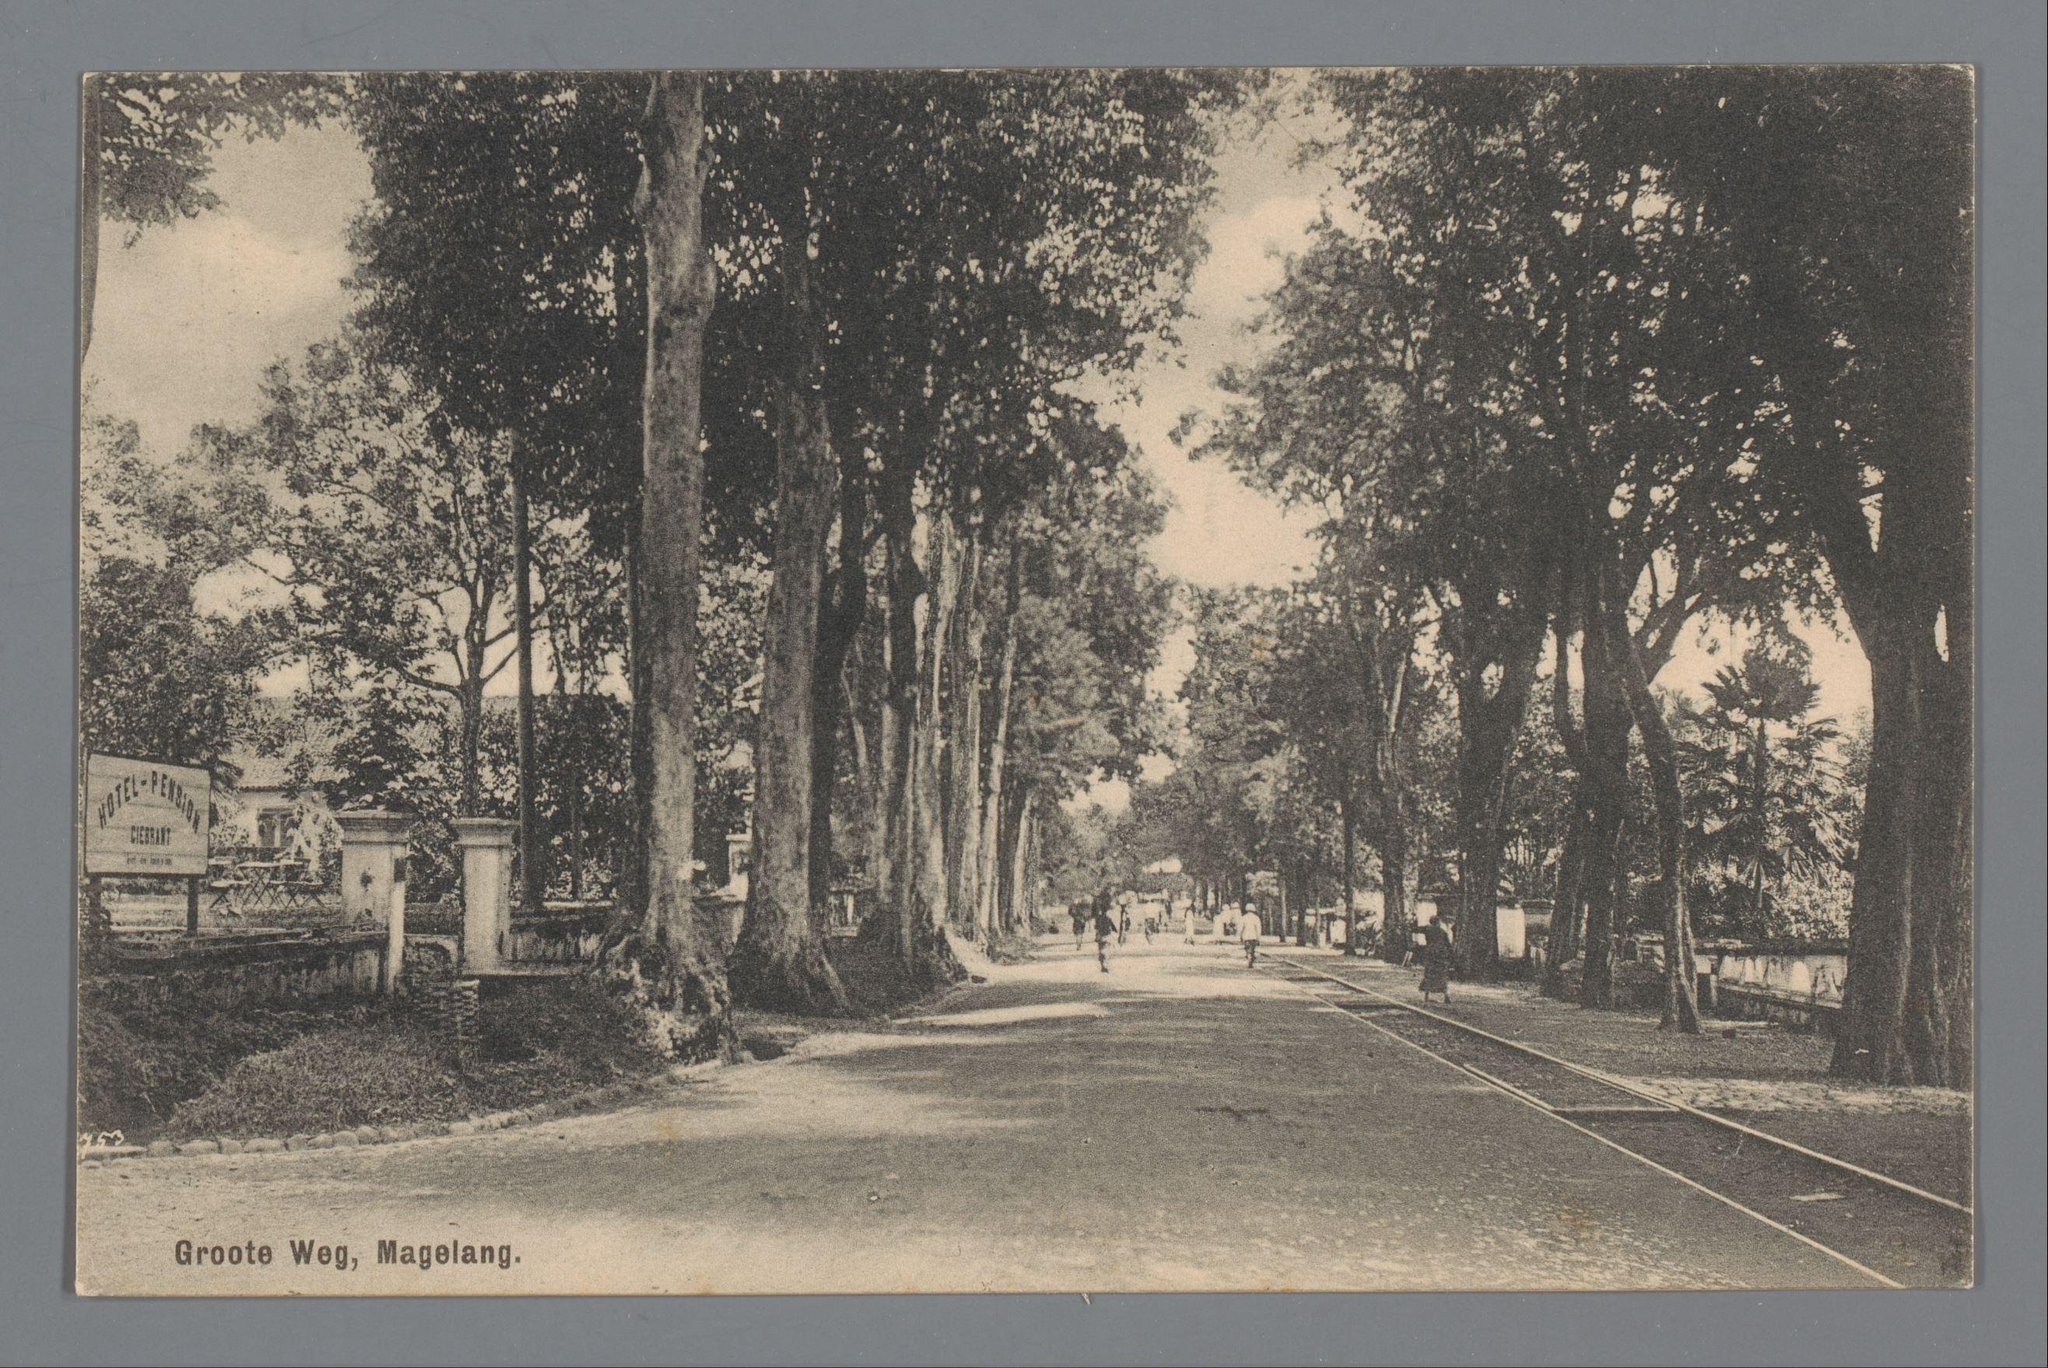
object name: photograph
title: Groote Weg, Magelang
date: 1900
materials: paper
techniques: photography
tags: dutch east indies, the